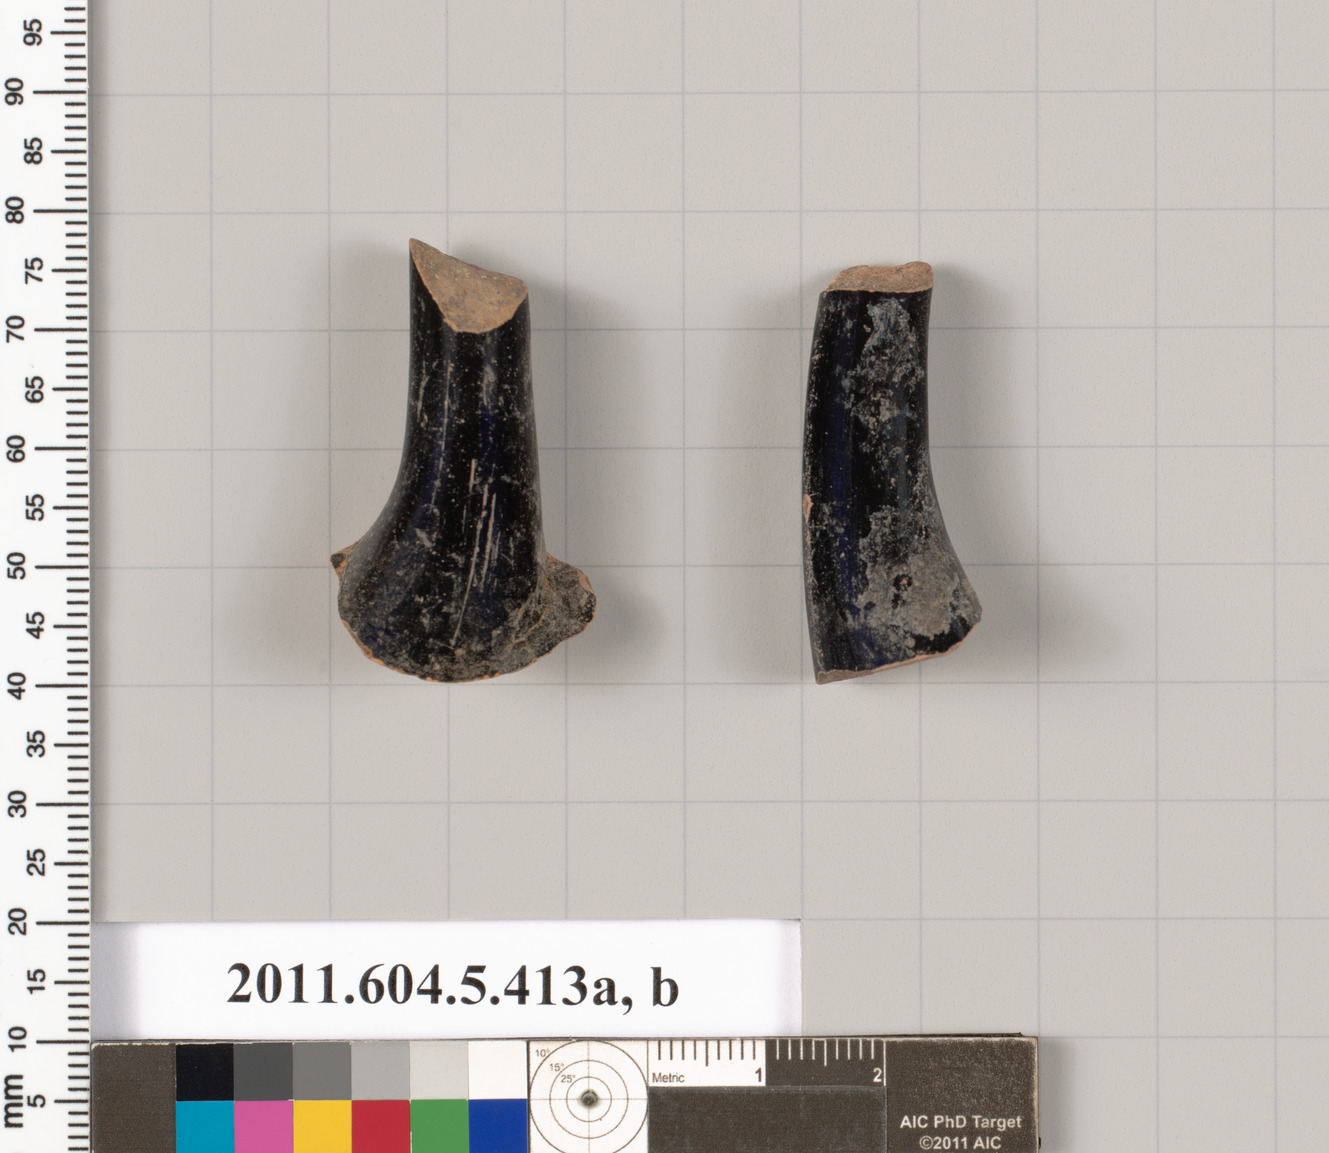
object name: kylix fragment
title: Terracotta fragments of kylikes (drinking cups)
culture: greek, attic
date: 600-401 BCE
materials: terracotta